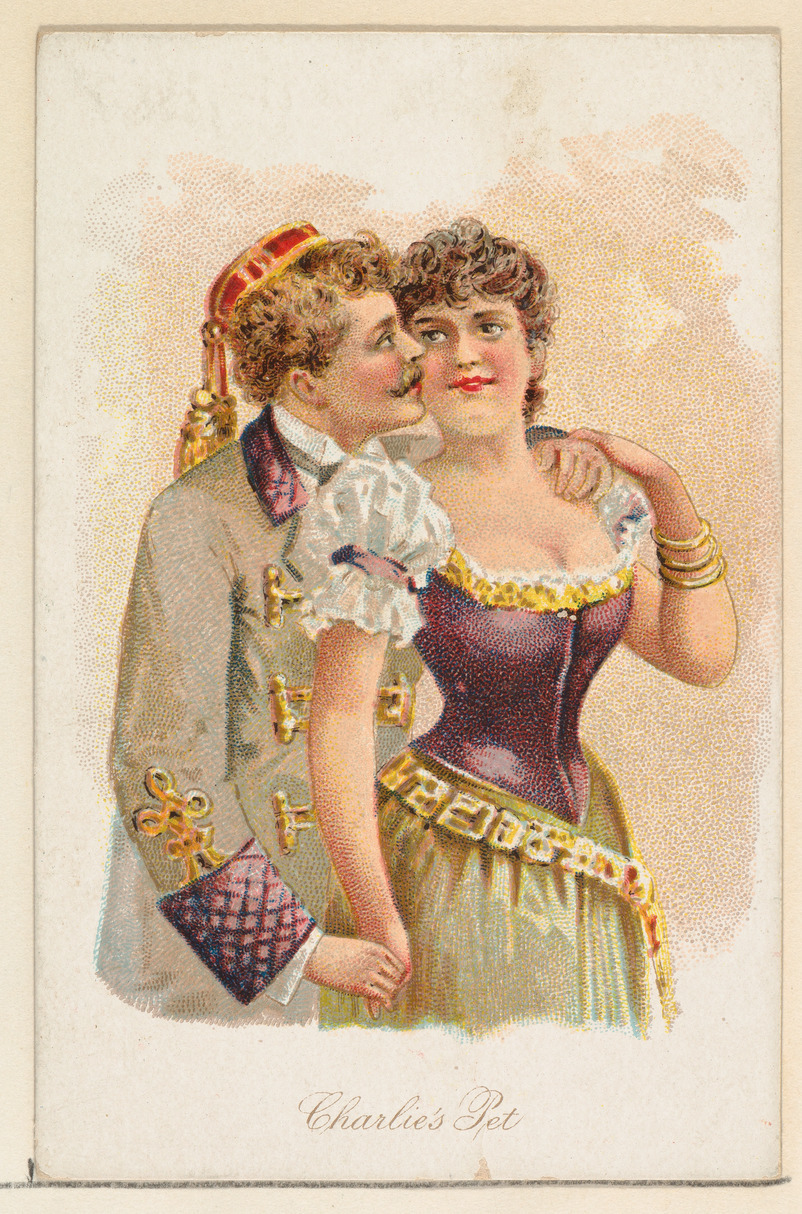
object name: print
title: Charlie's Pet, from the Household Pets series (N194) issued by Wm. S. Kimball & Co.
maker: william s. kimball & company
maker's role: publisher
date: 1891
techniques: color lithograph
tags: couples,men,women